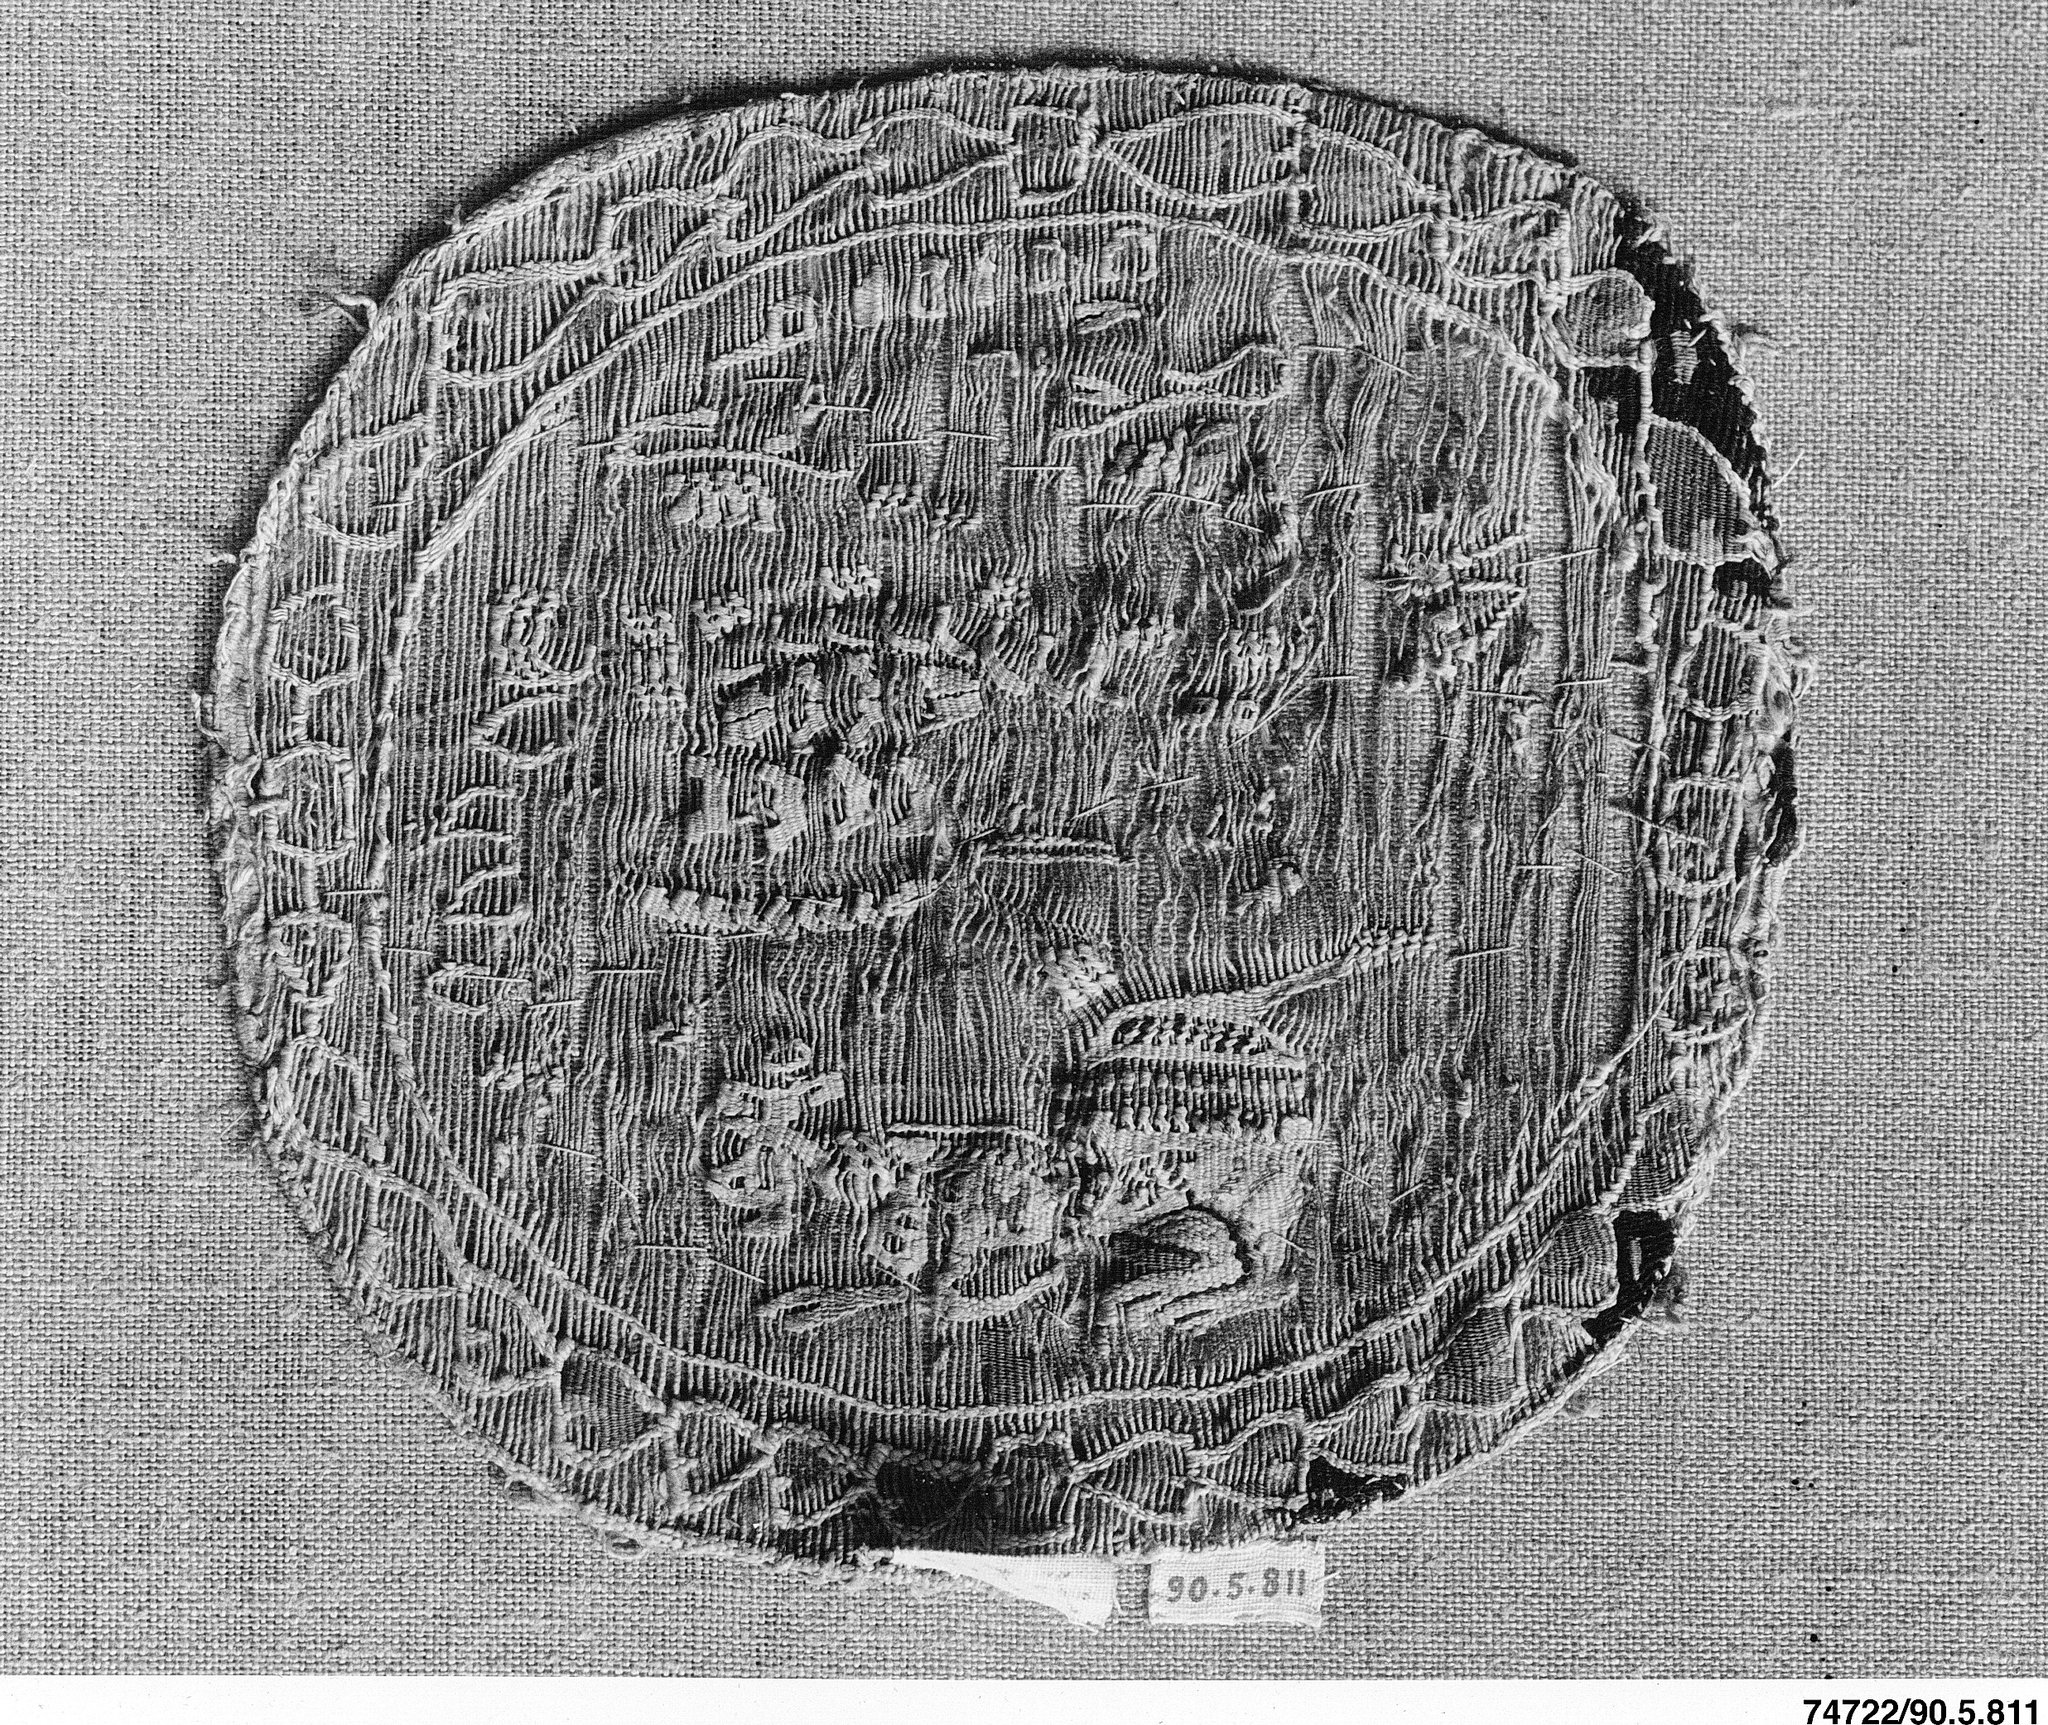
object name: textile fragment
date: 601-800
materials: linen, wool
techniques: weave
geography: egypt